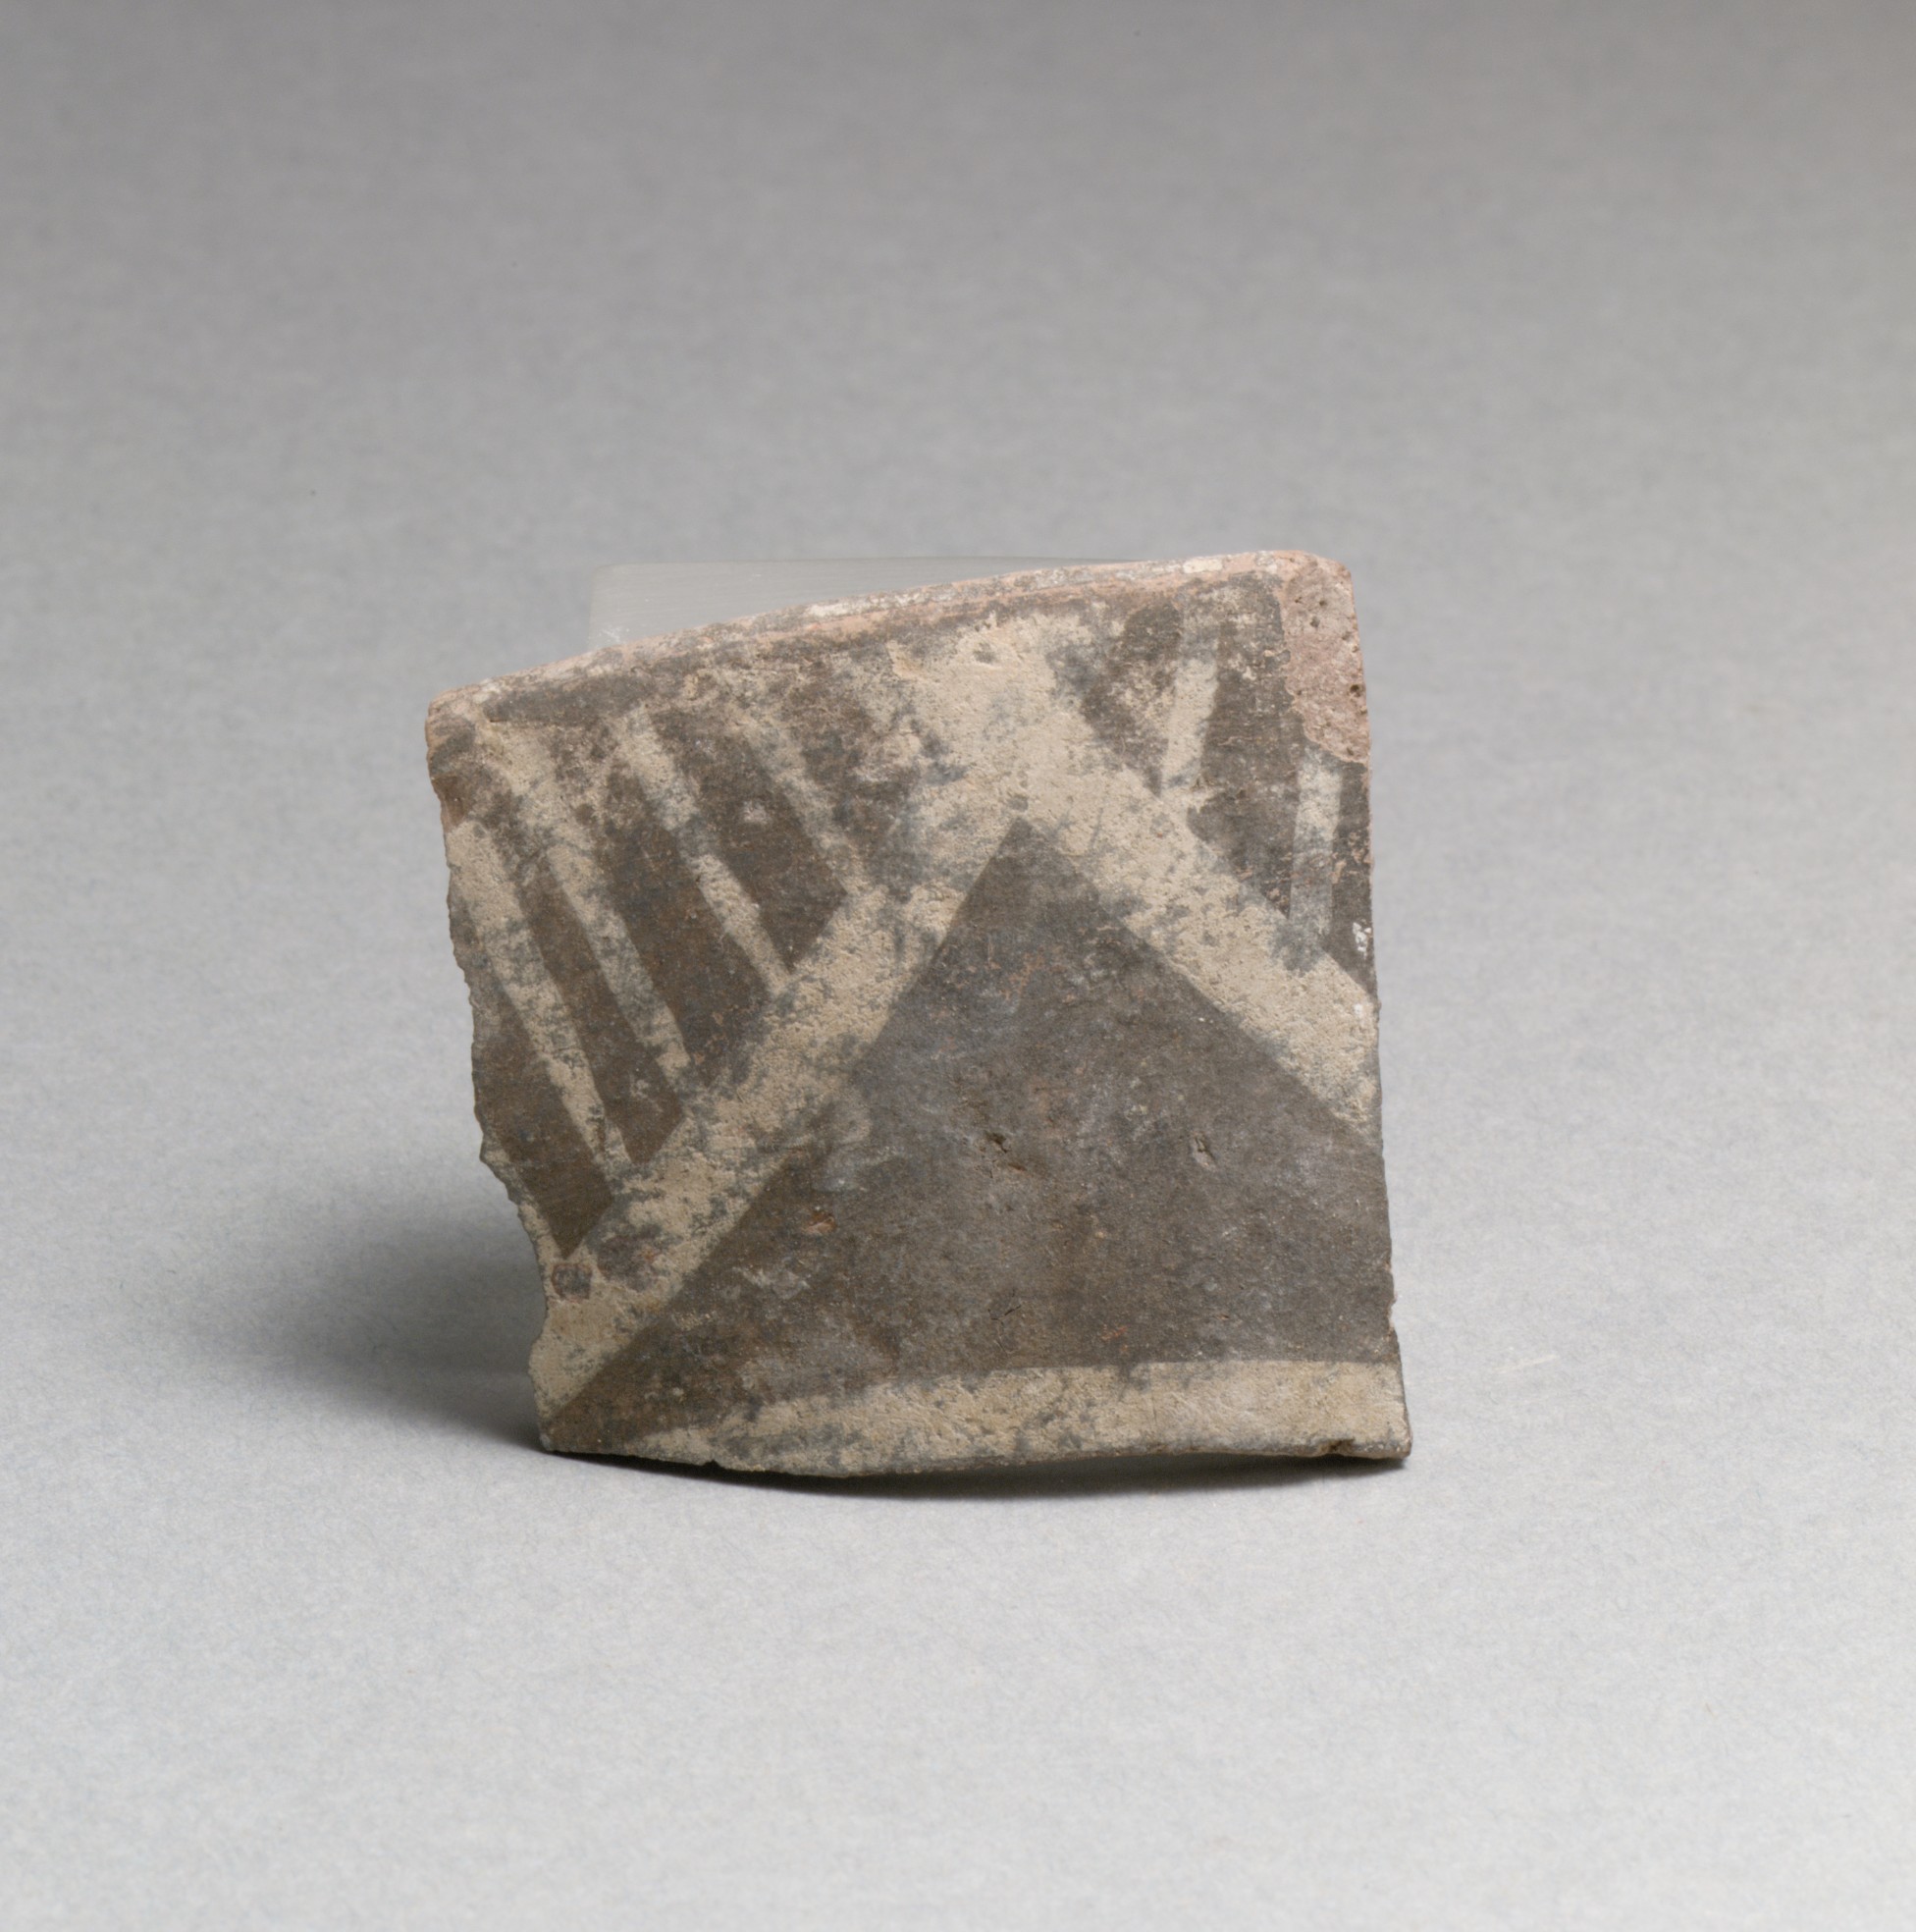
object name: vase fragment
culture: minoan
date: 2600-2000 BCE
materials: terracotta